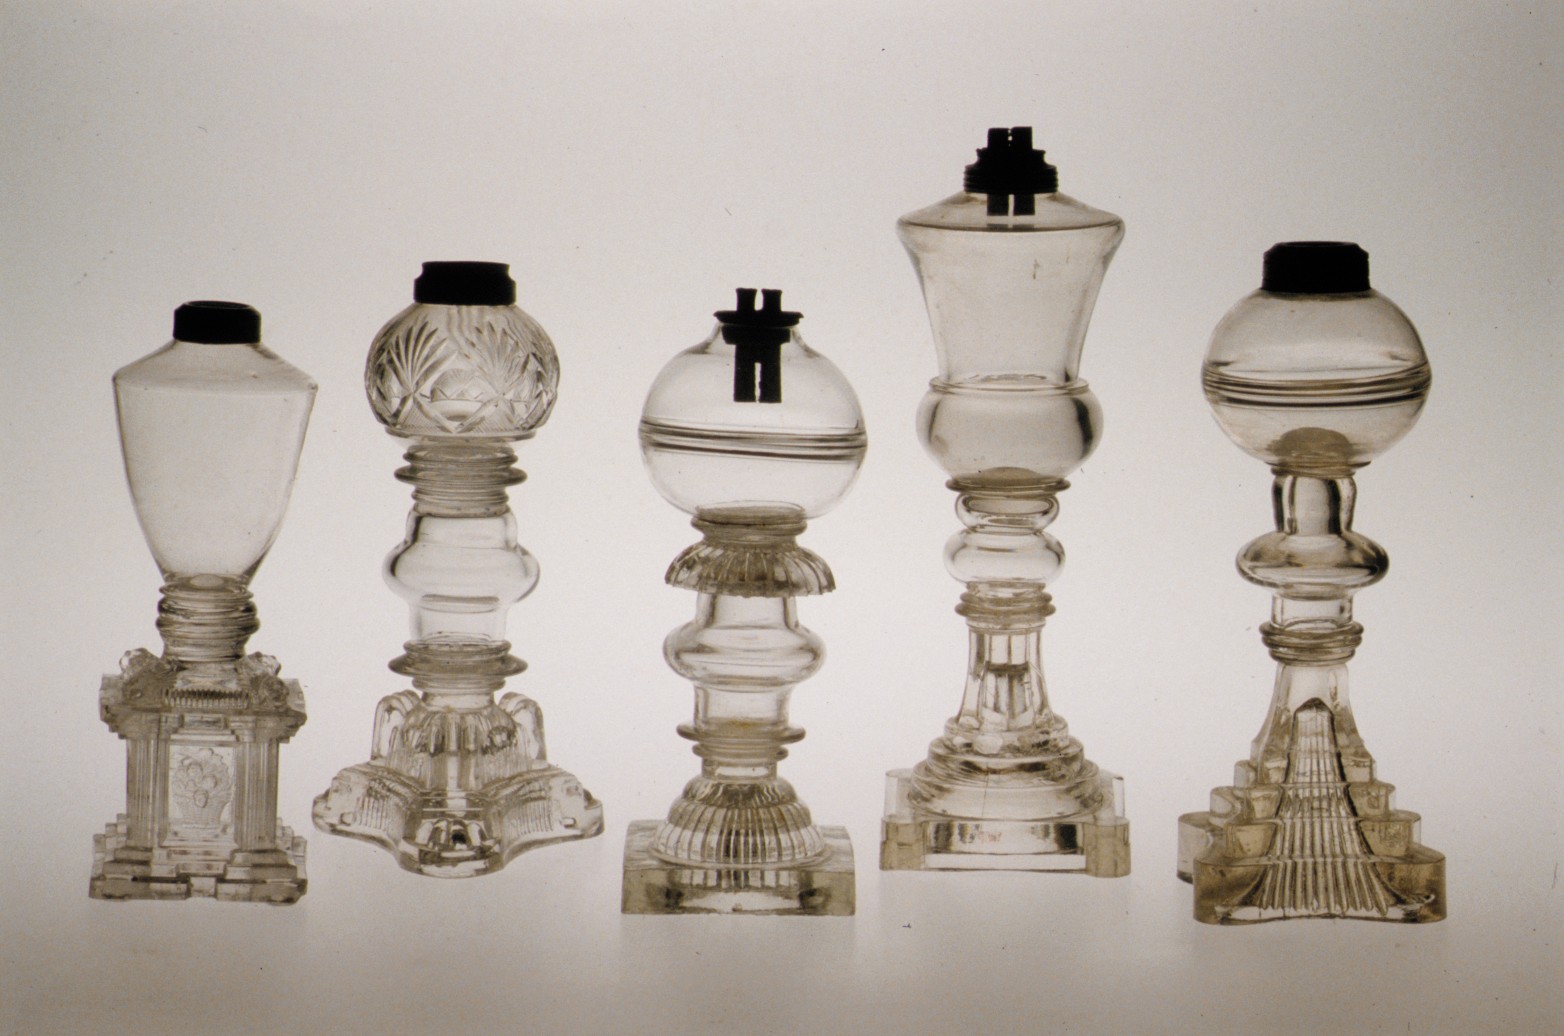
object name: whale oil lamp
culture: american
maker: thomas cains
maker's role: designer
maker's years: 1812-1820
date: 1813-1830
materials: glass, lead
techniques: glassblowing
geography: united states